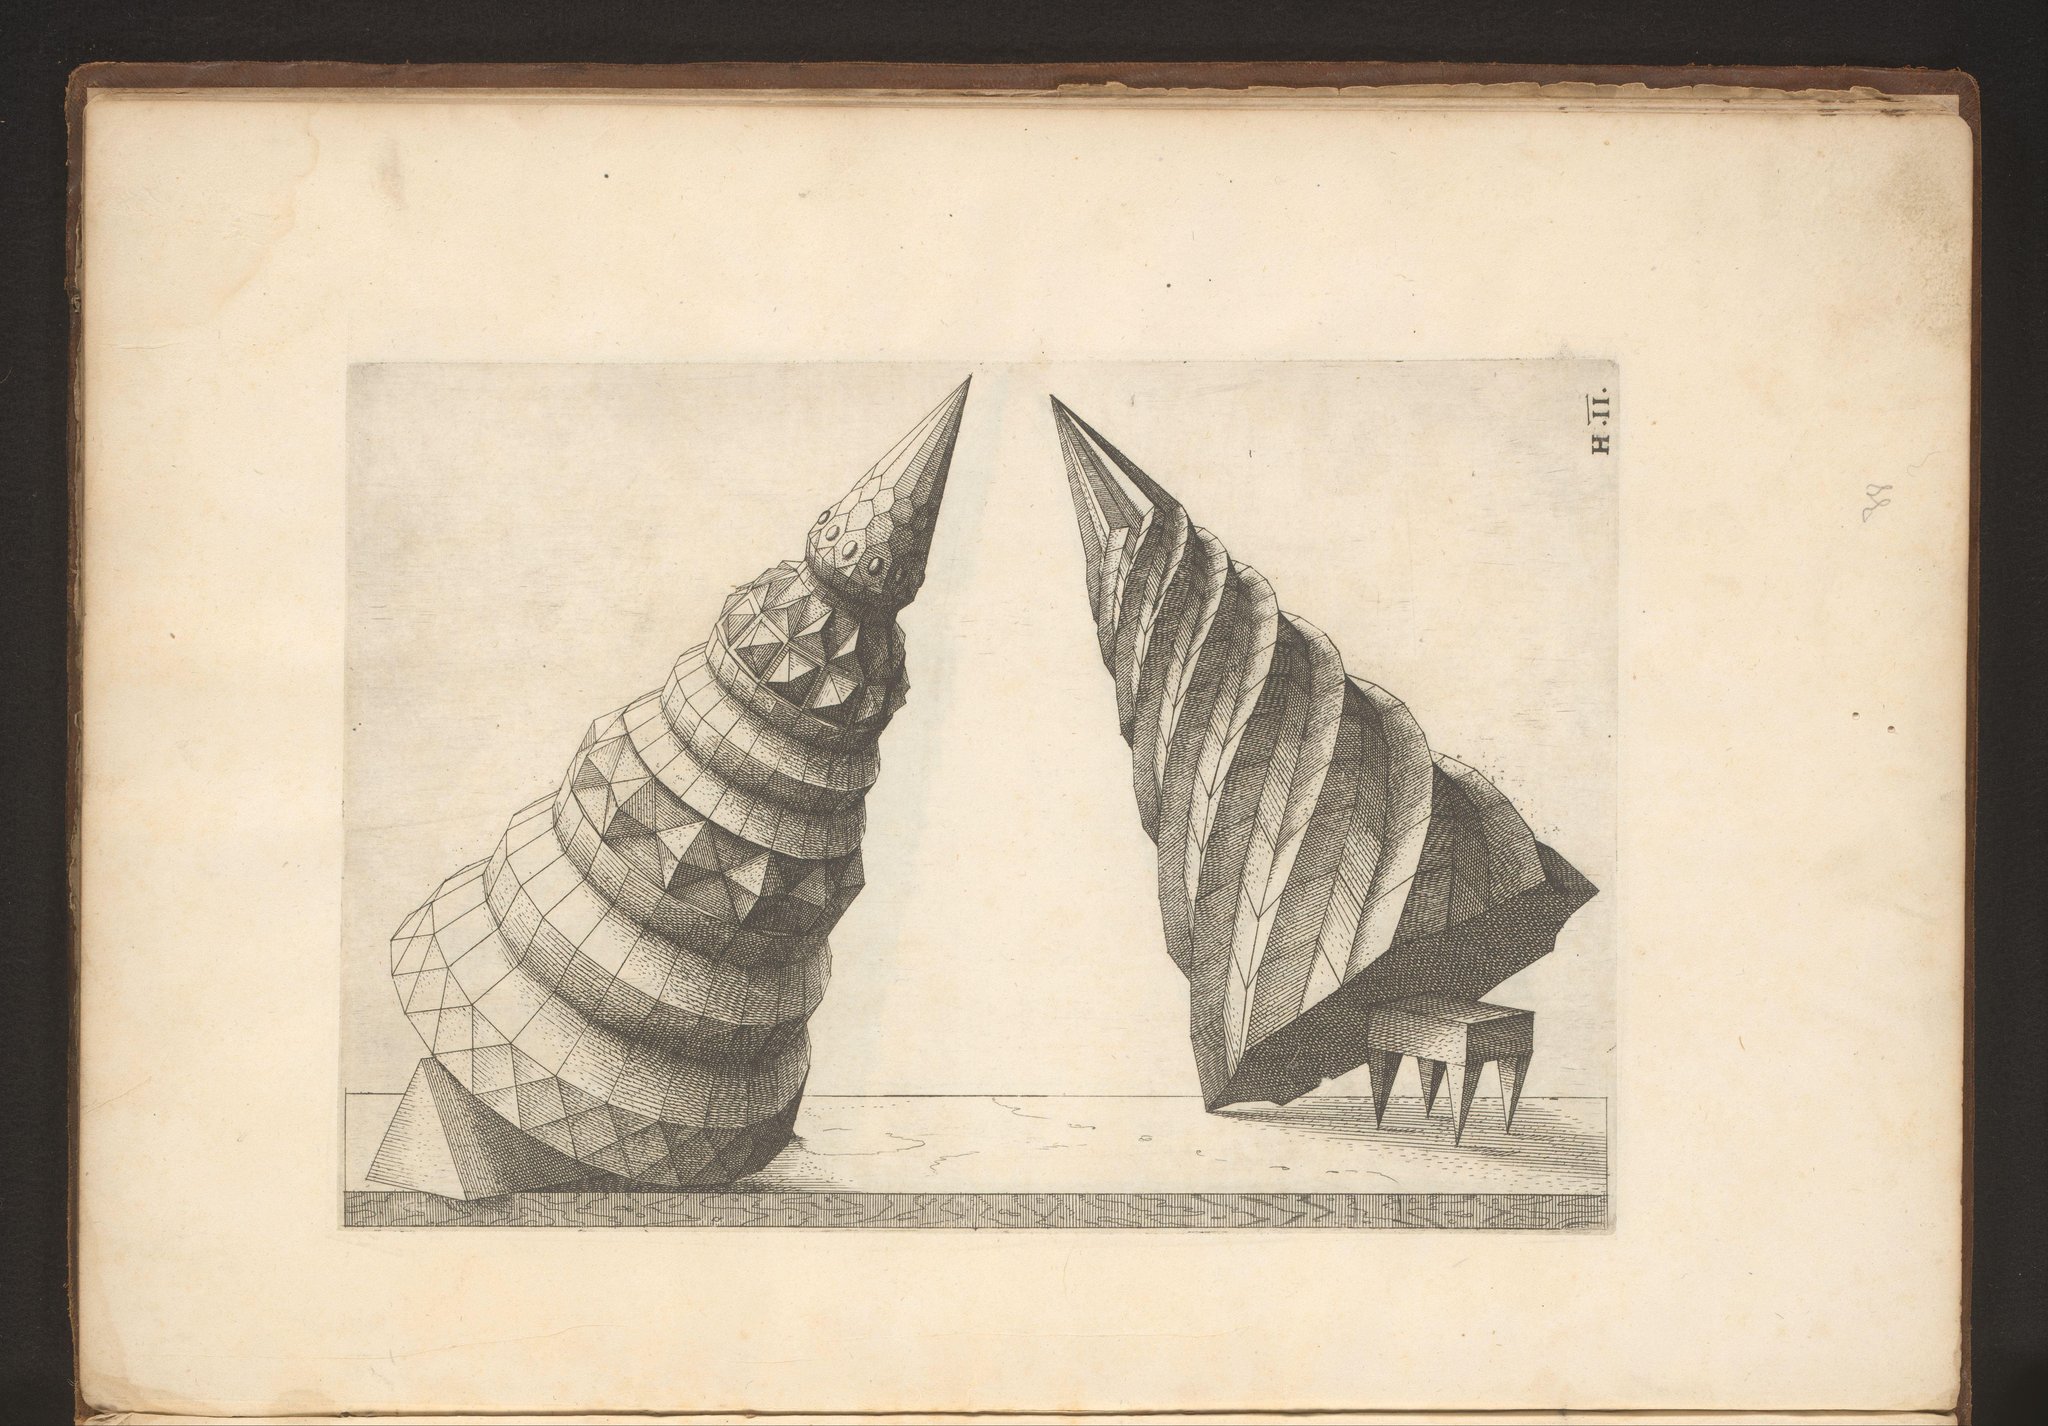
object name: book illustration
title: Twee veelvlakken met een kegel als uitgangspunt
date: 1568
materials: paper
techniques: etching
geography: nuremberg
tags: other polyhedrons, cone ~ stereometry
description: Prent uit: Jamnitzer, Wenzel. Perspectiva corporum regularium (...). Neurenberg: Wenzel Jamnitzer, 1568.